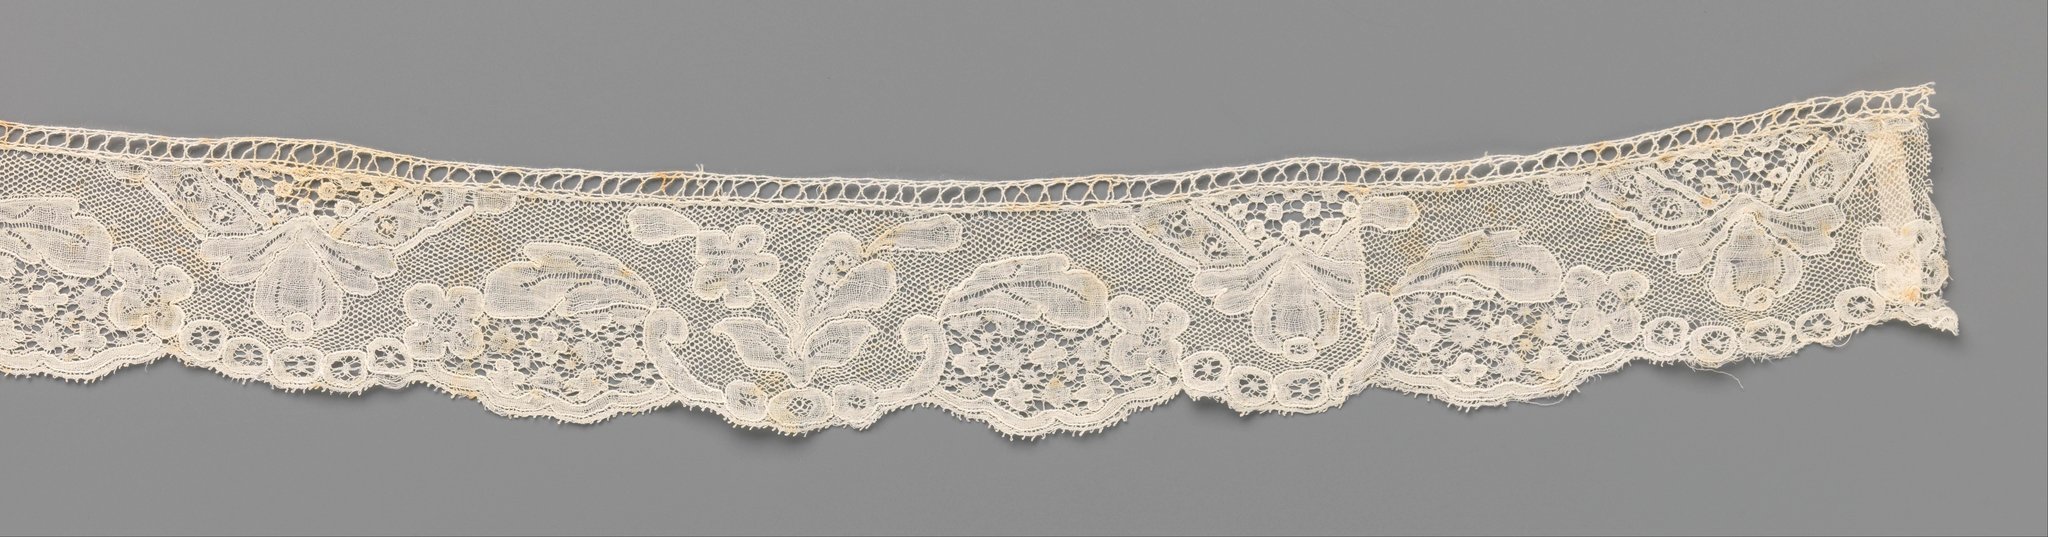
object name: strip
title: Strook kloskant met hangend driehoekig cartouche met peervormige bloem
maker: Anonymous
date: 1740-1760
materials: linen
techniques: lace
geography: mechelen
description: Strook naturelkleurige kloskant: Mechelse kant. Het zich herhalende patroon bestaat langs de bovenzijde uit een hangende driehoekige cartouche, met een peervormige bloem tussen twee hartvormige blaadjes. De cartouche wordt afgewisseld door een rozetbloem, die met twee blaadjes en één groot hartvormig blad ontspringt uit het doorlopende patroon langs de onderzijde. Recht onder de driehoek bestaat dit patroon uit vijf aaneengeschakelde cirkeltjes met links en rechts een vierlobbige rozetbloem. Het patroon waaruit de rozetbloem ontspringt bestaat uit twee c-voluten waaruit een groot blad zijwaarts afbuigt. De motieven zijn met elkaar verbonden door een fijne maasgrond, de Mechelse grond. De motieven zijn gemaakt in linnenslag met uitsparingen en met dikkere en glimmende contourdraden. Siergronden met grote mazen, sneeuwvlokken en rozetjes zijn toegepast in onder andere het cartouche en onder het zijwaarts afbuigende blad in het patroon langs de onderzijde. De bovenzijde is afgewerkt met een apart geklost bandje, met grote mazen en waarbij gewerkt is met grovere draden. De geschulpte onderzijde volgt het patroon en is afgewerkt met picots.